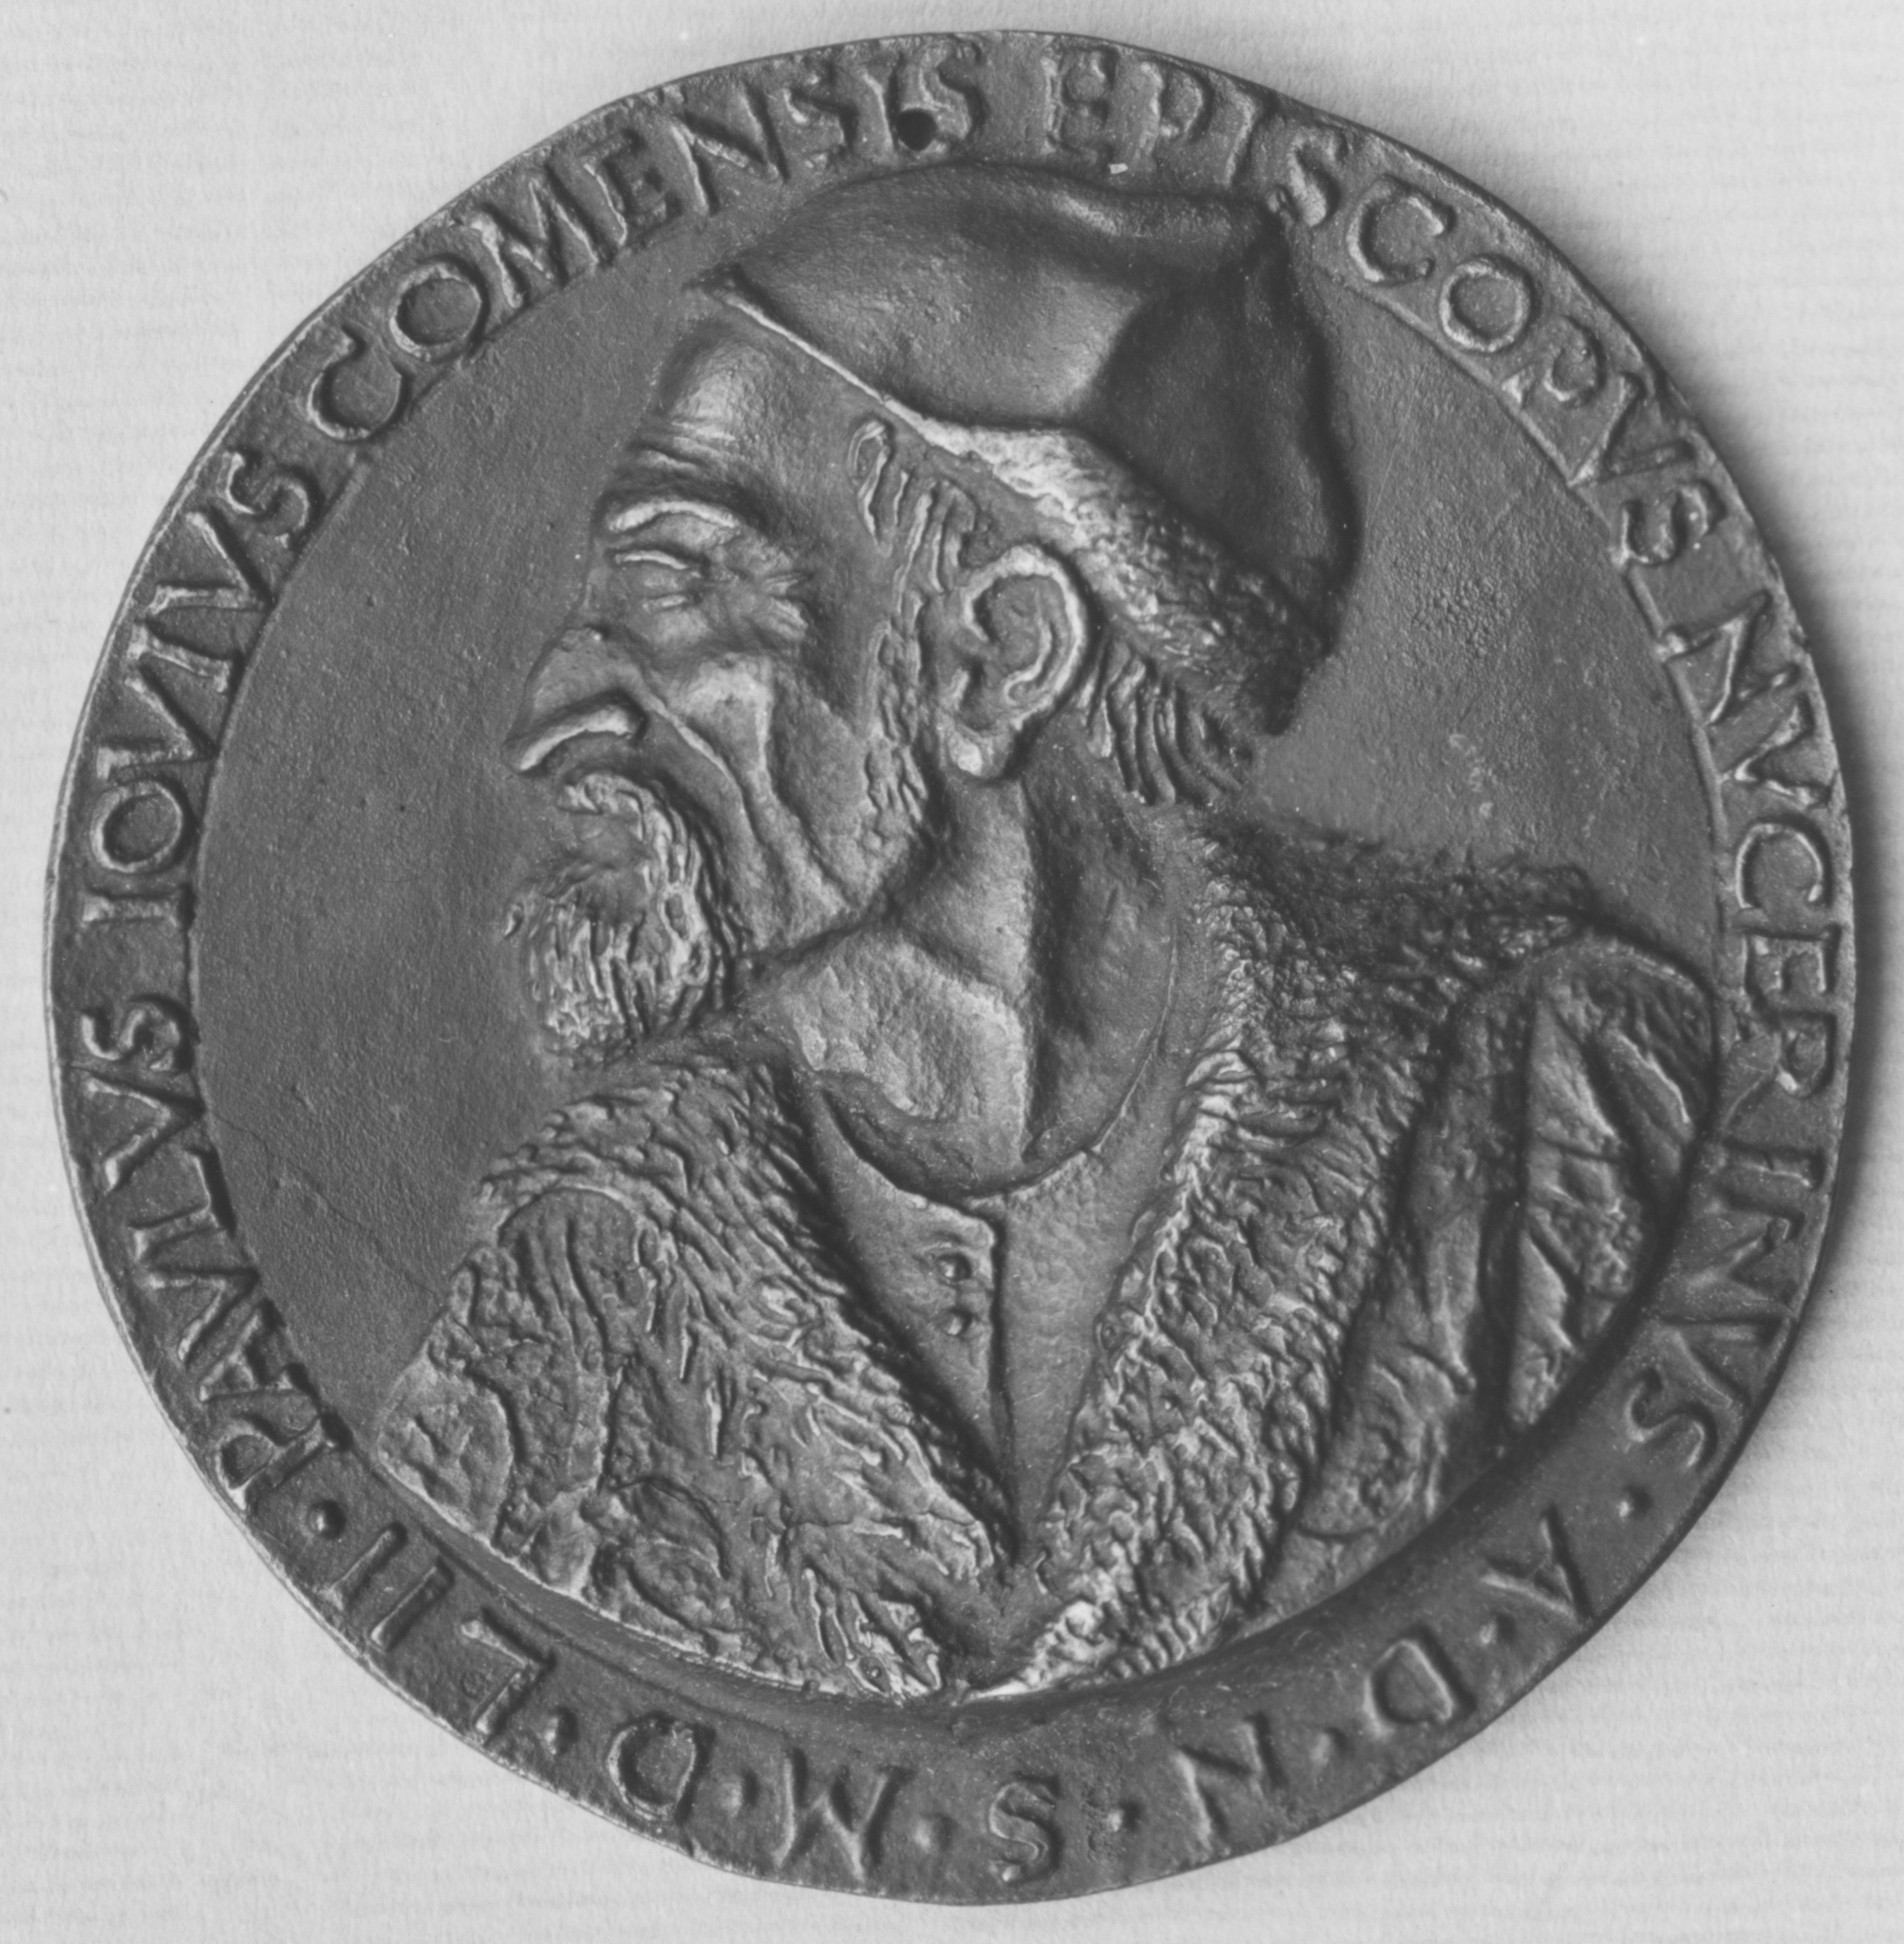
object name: medal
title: Paolo Giovio, Historian and Prelate, Bishop of Nocera (d. 1552)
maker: francesco da sangallo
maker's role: artist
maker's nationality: italian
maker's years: 1494-1576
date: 1552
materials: bronze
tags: men,portraits,profiles